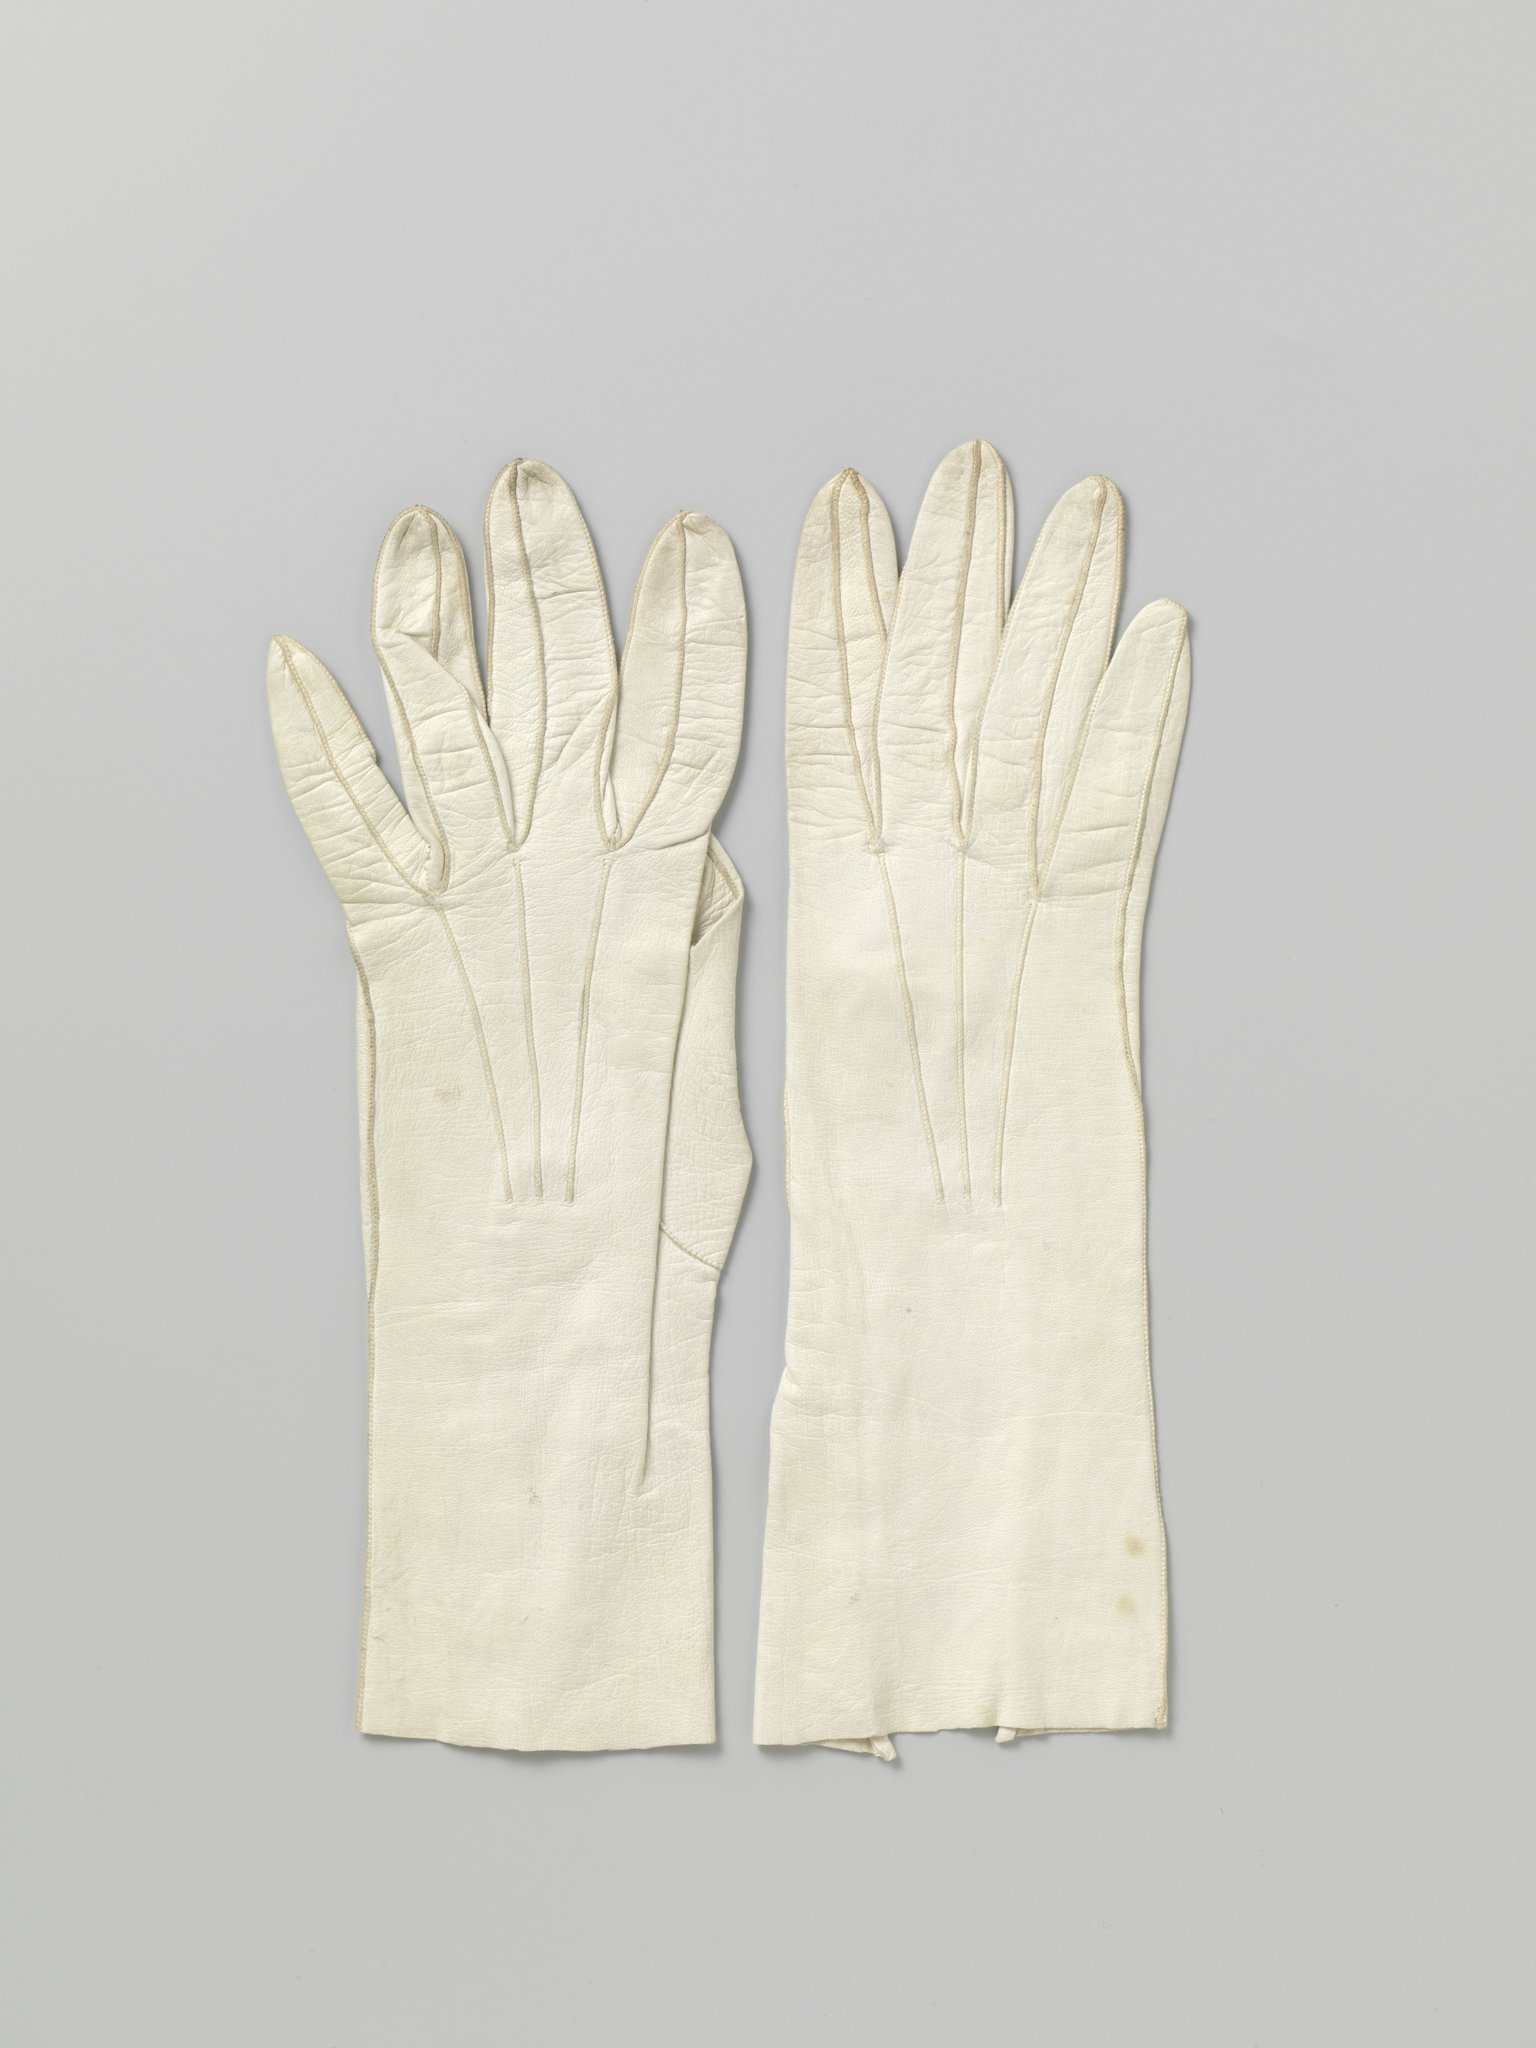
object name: glove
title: Handschoen van wit kalfsleer en sluiting met vier parelmoeren knopen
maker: Anonymous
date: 1900-1950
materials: leather, mother of pearl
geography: western europe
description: Linker handschoenen van wit kalfsleer en sluiting met vier parelmoeren knopen. Kort model, waarschijnlijk van oorsprong lang en later afgeknipt.